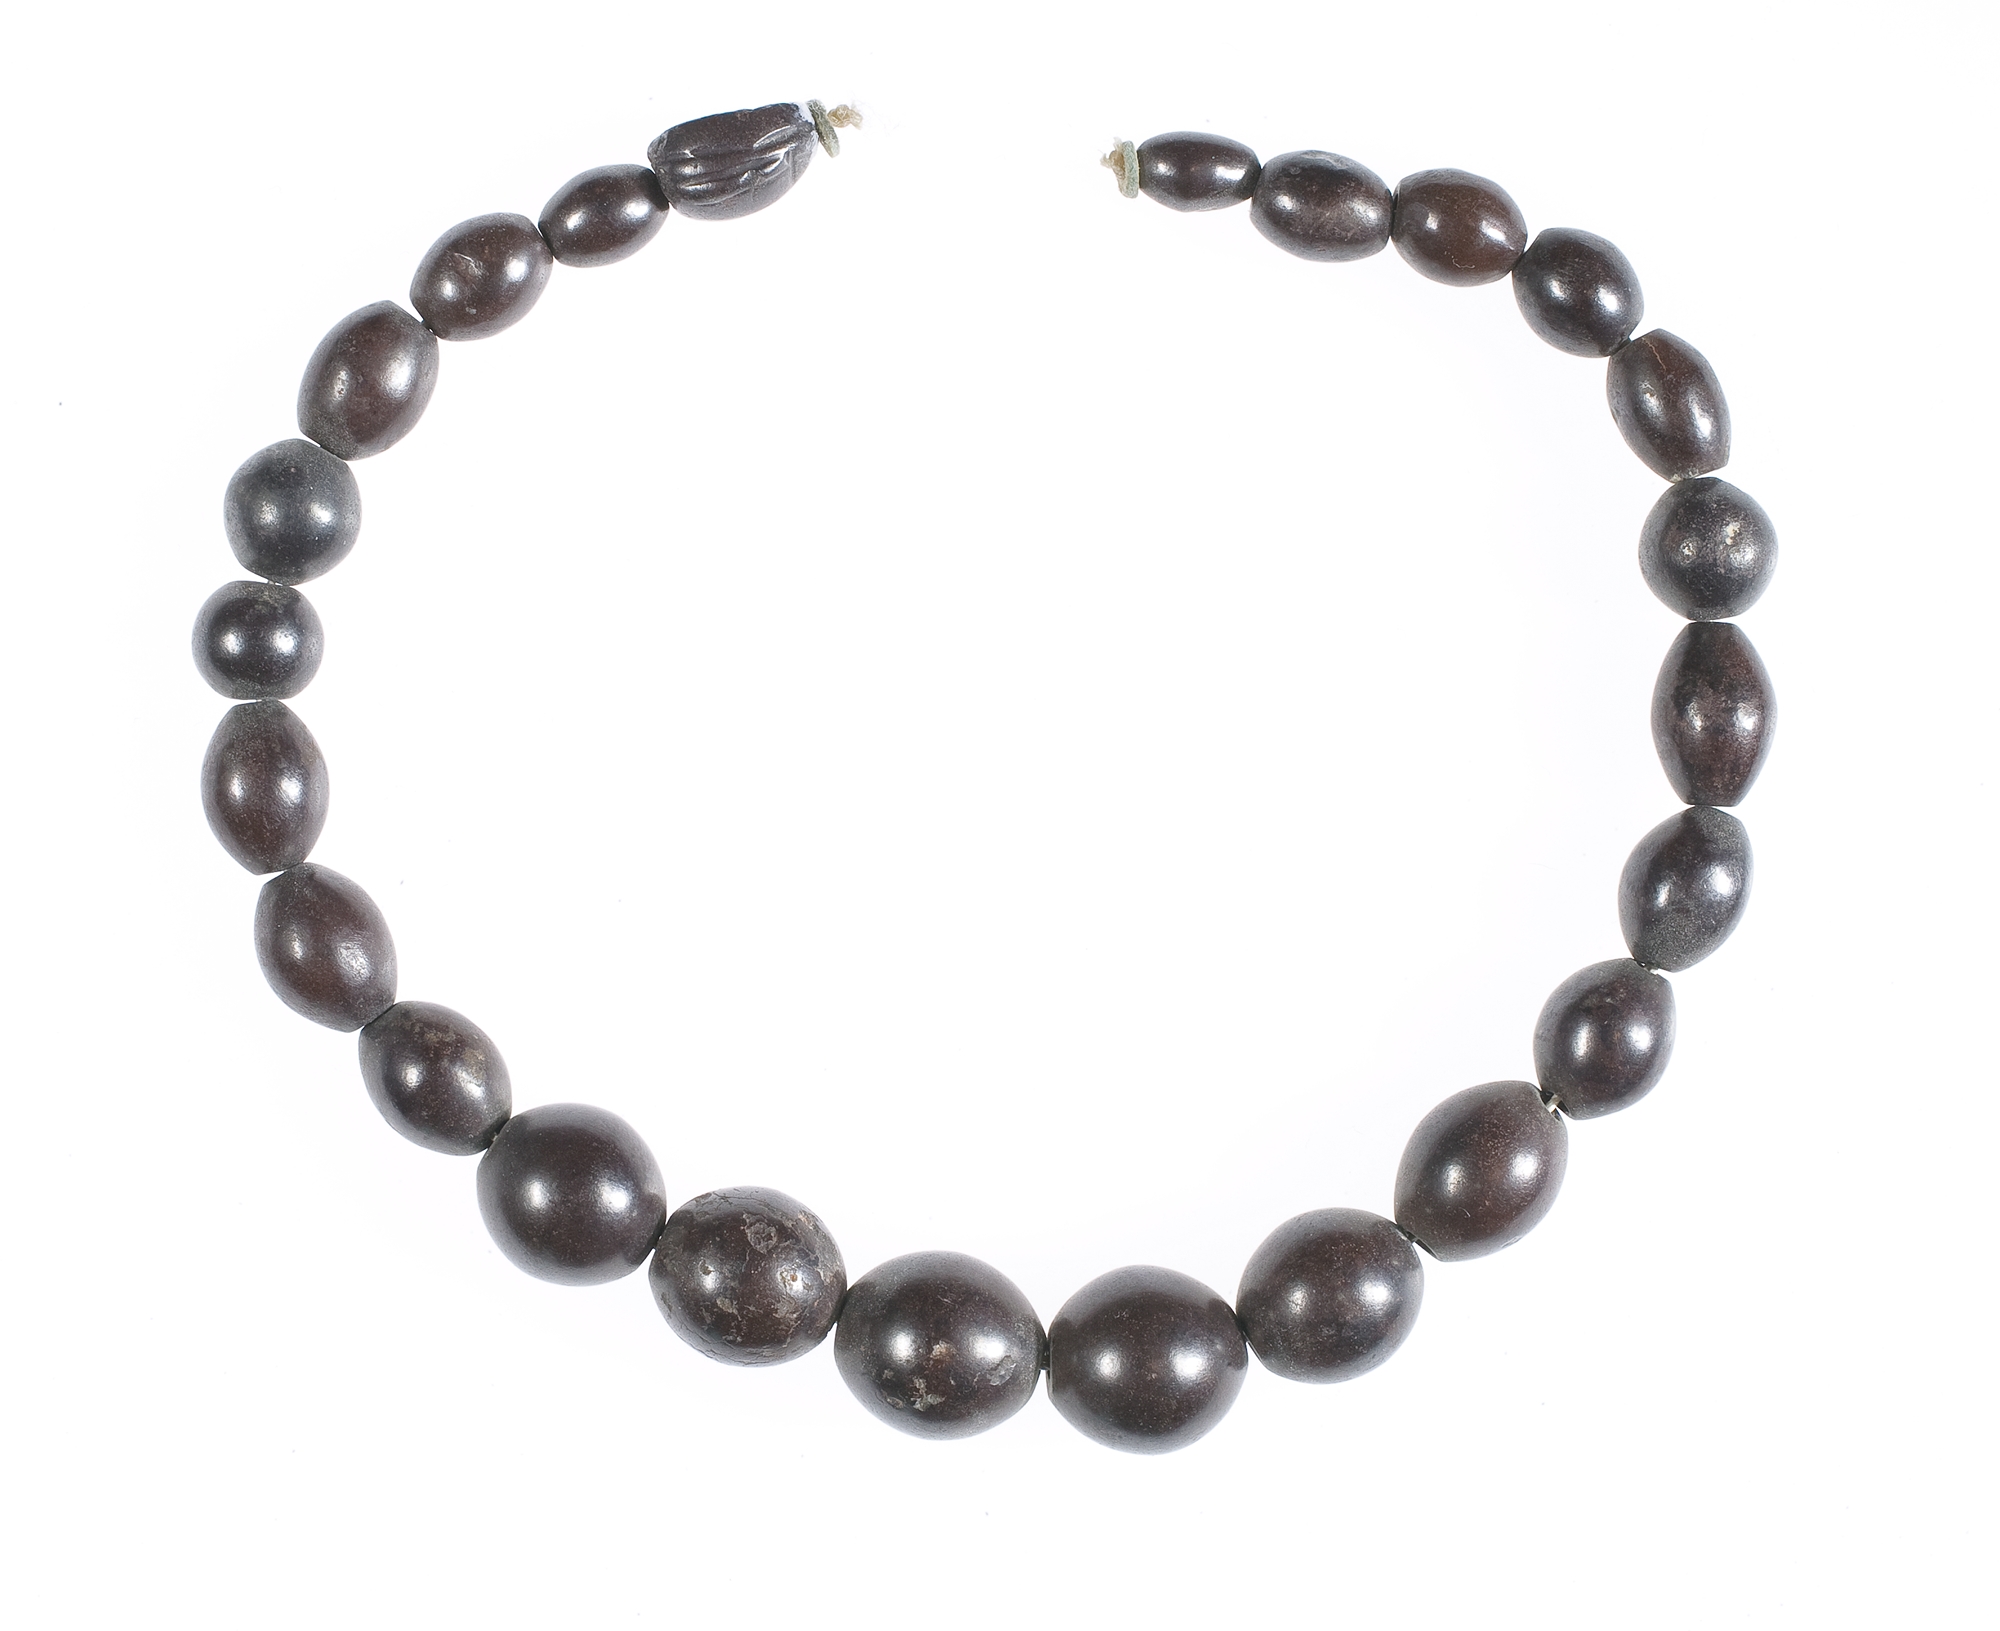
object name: necklace, bead, scarab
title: Necklace with beads and a scarab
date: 1991-1450 BCE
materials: mineral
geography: egypt